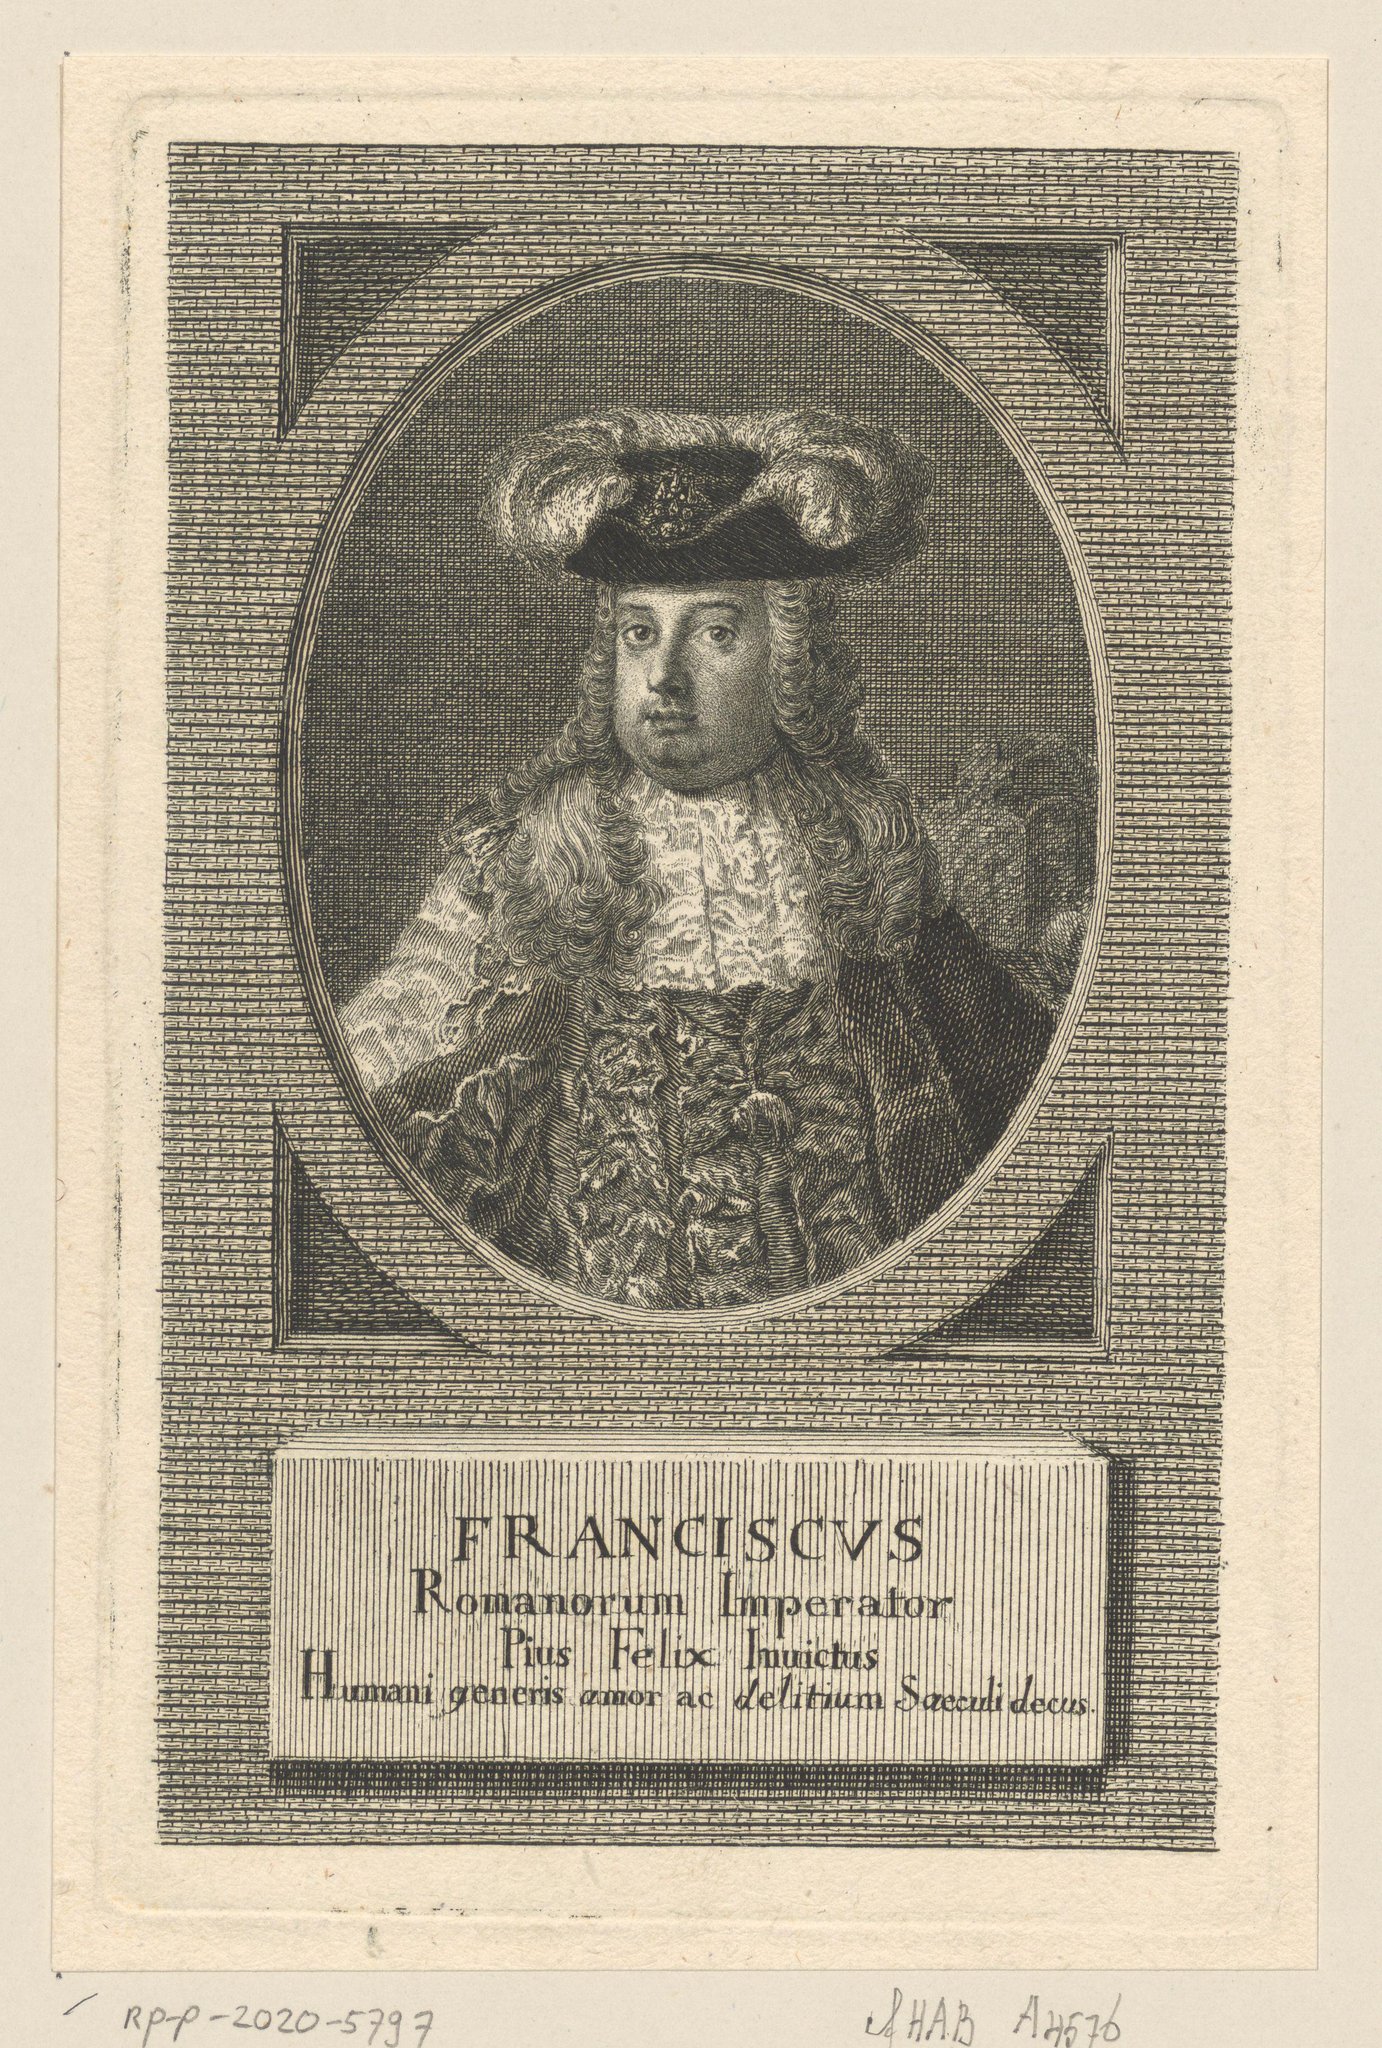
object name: print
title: Portret van keizer Frans I Stefan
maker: Anonymous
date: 1745-1800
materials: paper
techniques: engraving, etching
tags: frans i stefan (duits keizer), historical persons, emperor